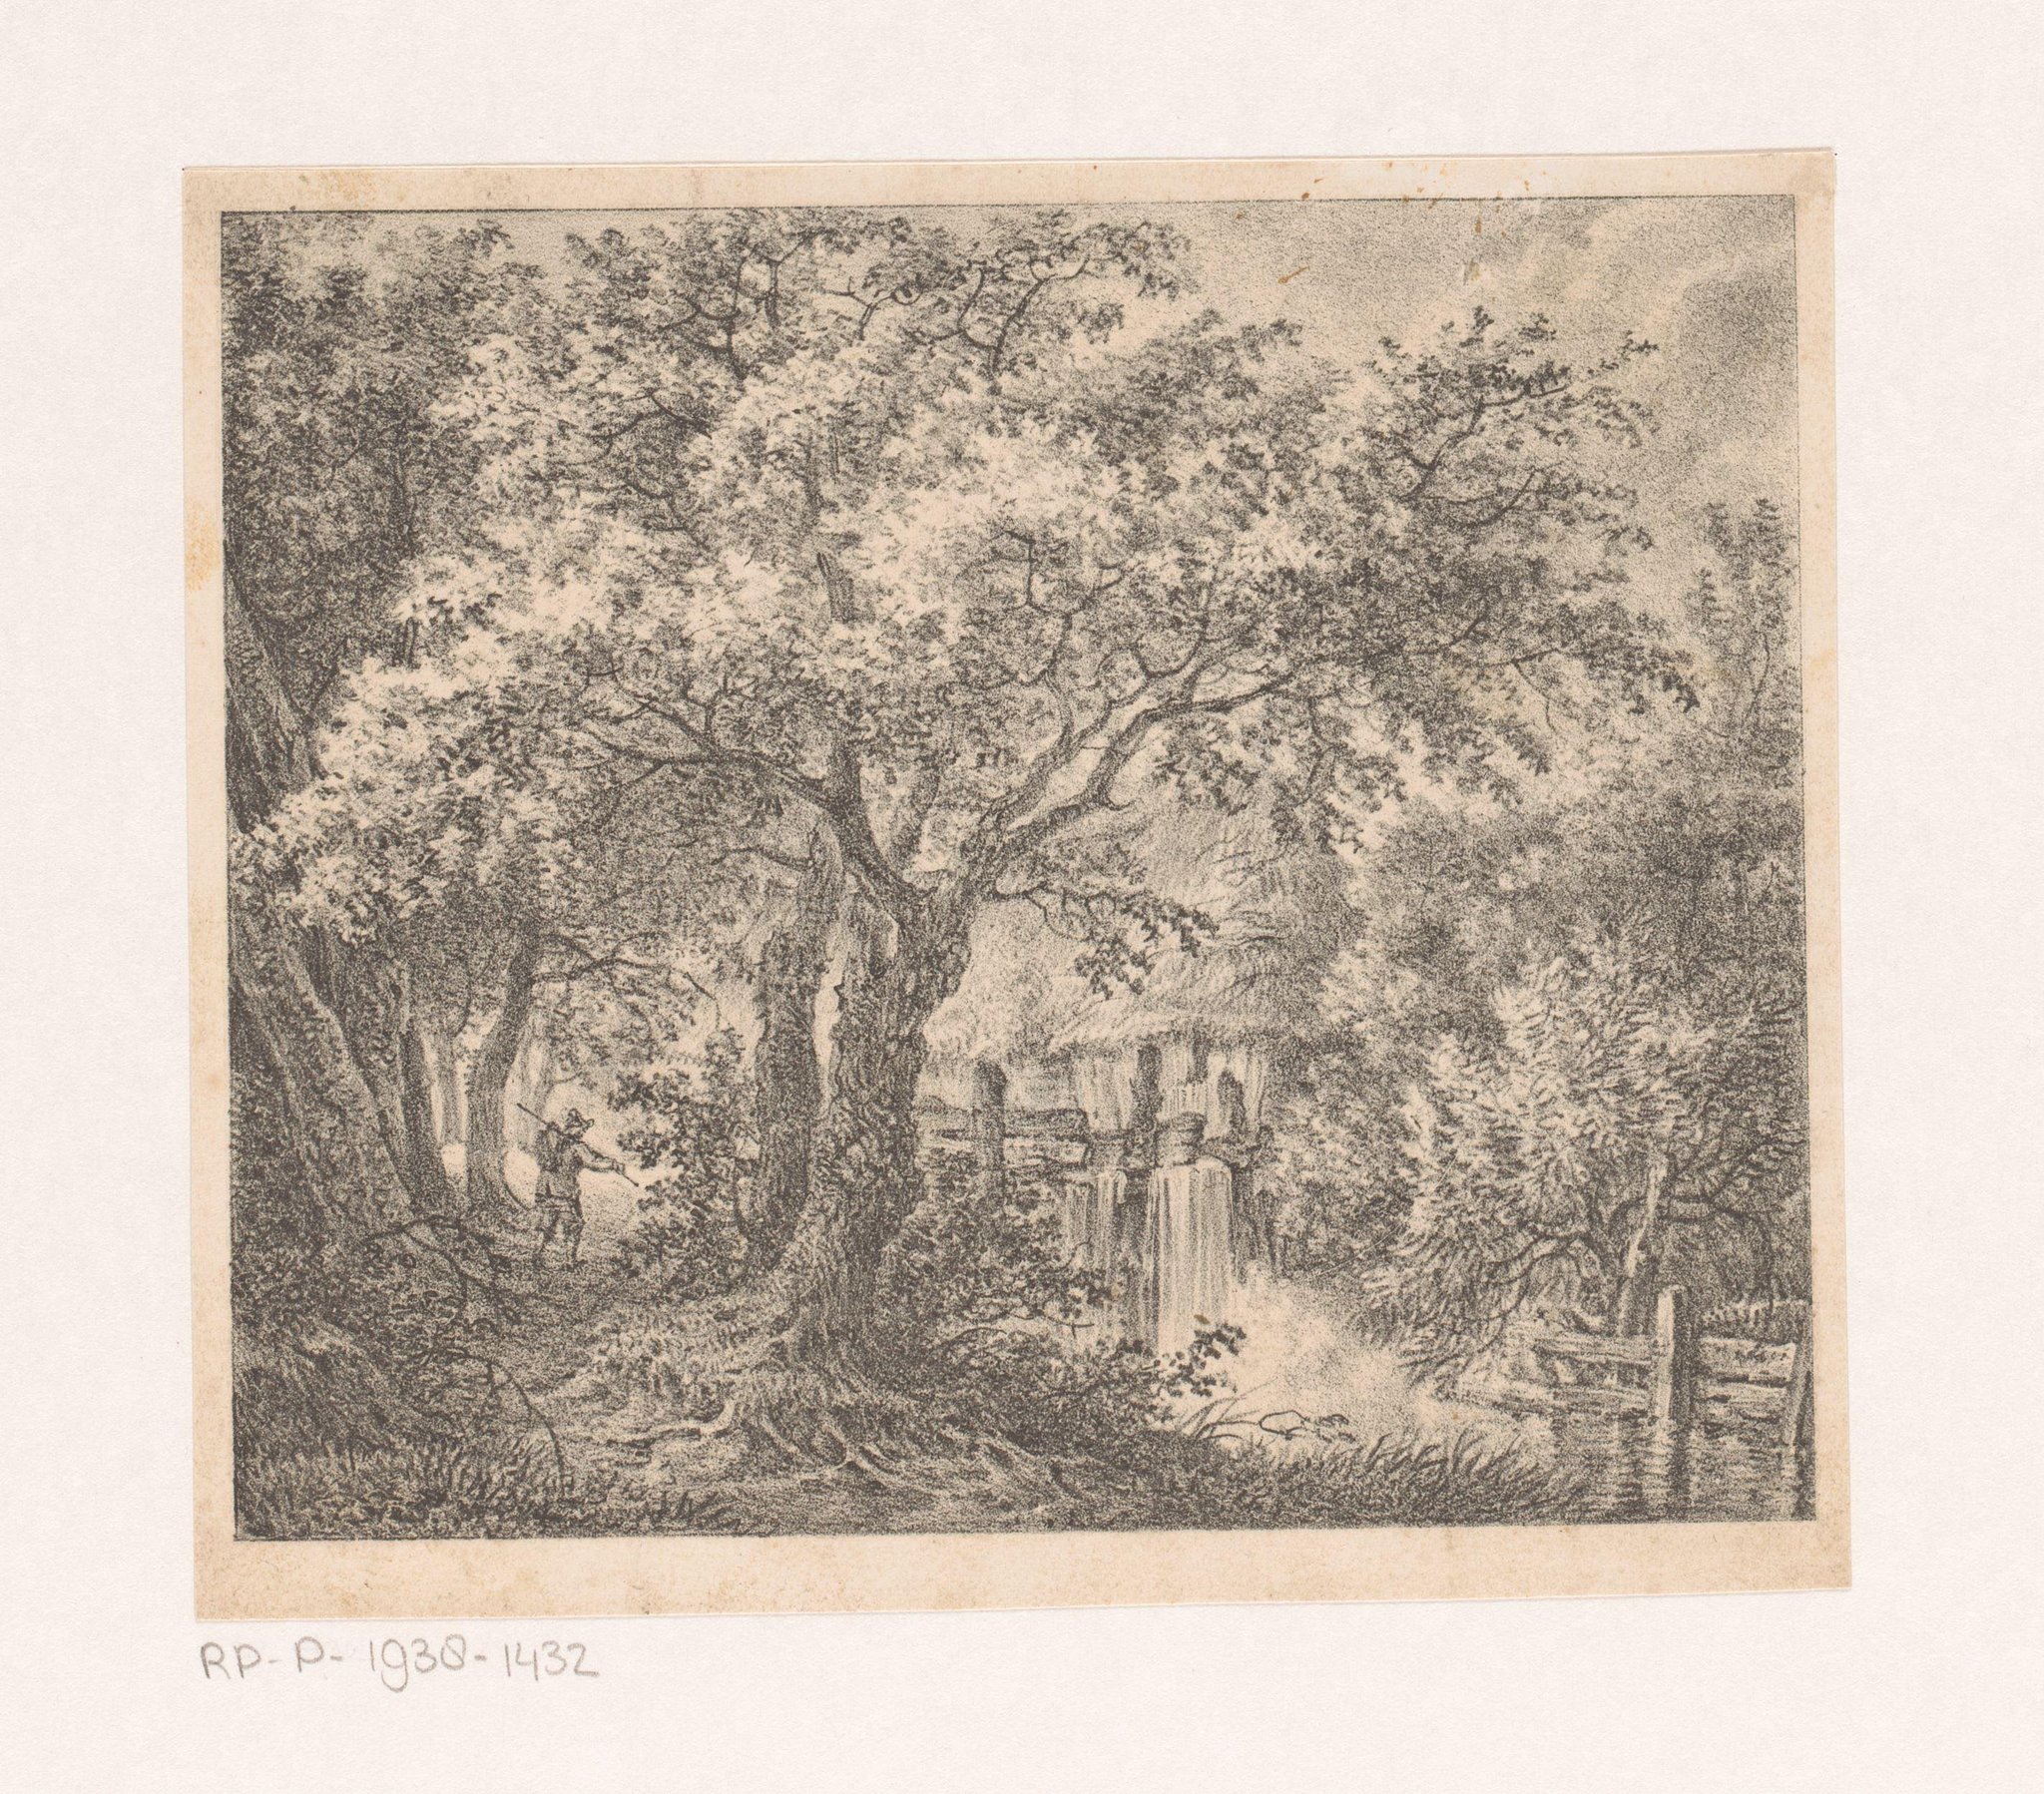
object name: print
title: Watermolen in bos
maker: françois joseph pfeiffer (ii)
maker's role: draughtsman, print maker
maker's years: 1778-1835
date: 1810-1830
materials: paper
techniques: lithograph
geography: amsterdam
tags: watermill in landscape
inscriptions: collector's mark: Lugt 2760, collector's mark: Lugt 2228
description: Watermolen omgeven door bomen. Links op een pad loopt een man met plunjezak.